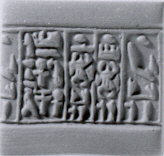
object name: cylinder seal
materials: stone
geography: egypt (?)